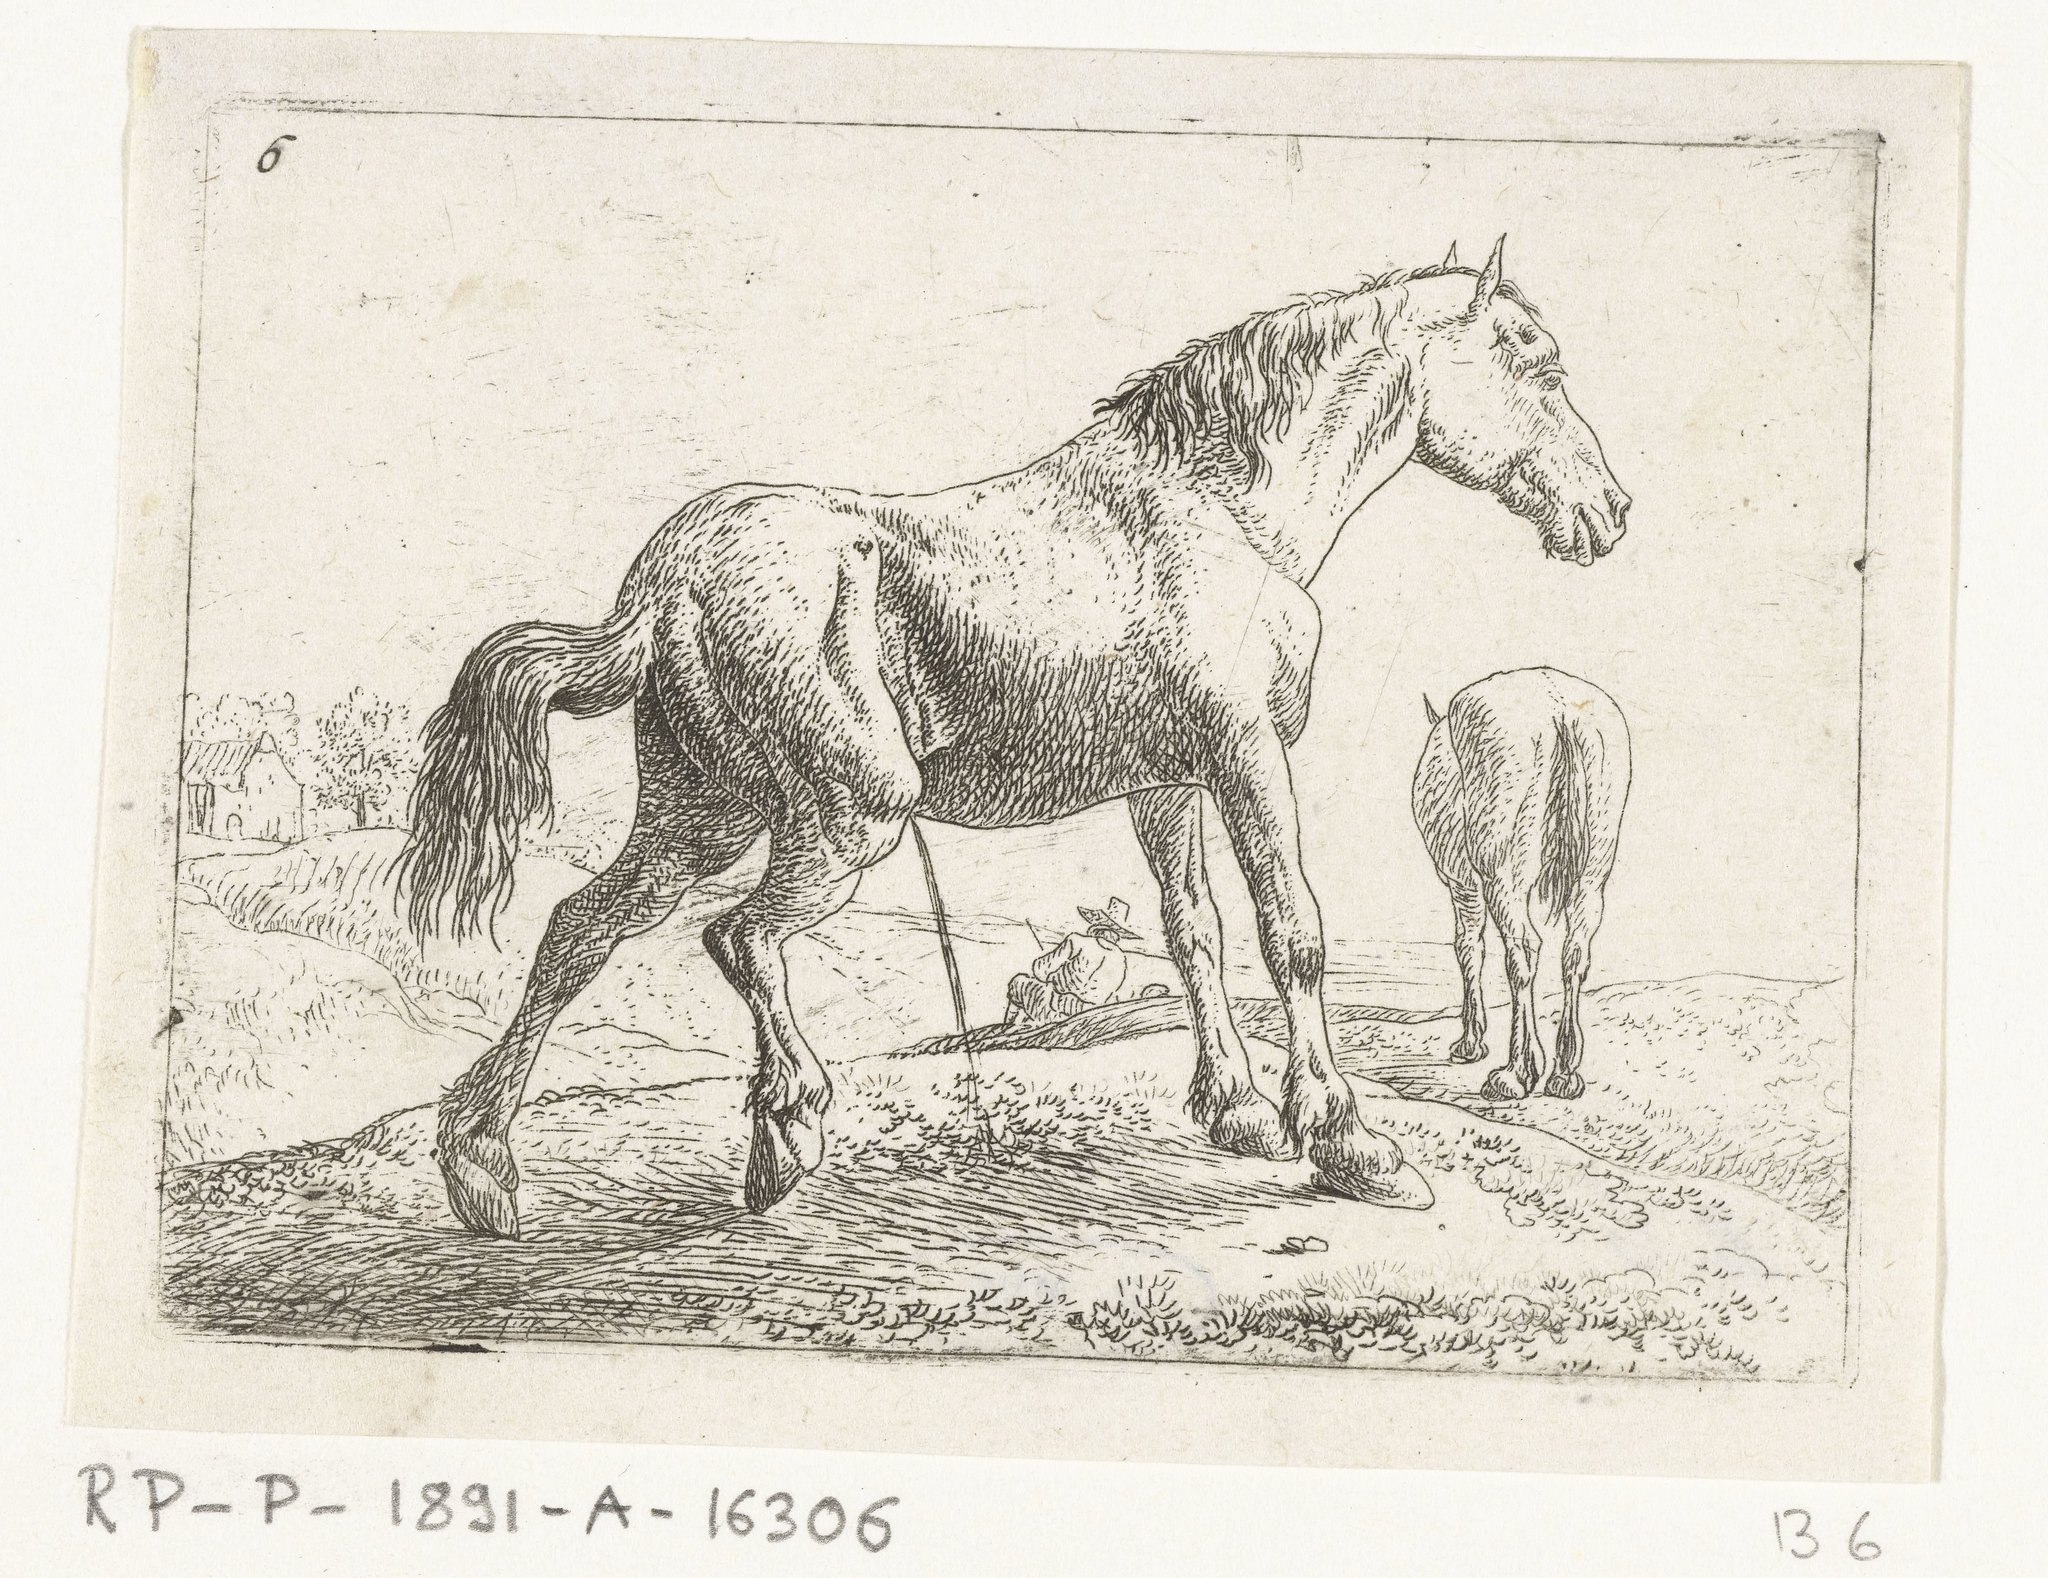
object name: print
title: Pissend paard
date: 1624-1661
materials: paper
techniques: etching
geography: amsterdam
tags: horse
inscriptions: collector's mark: Lugt 2228a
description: Landschap met op de voorgrond een pissend paard. Op de achtergrond in het midden zit een man, rechts staat een tweede paard.